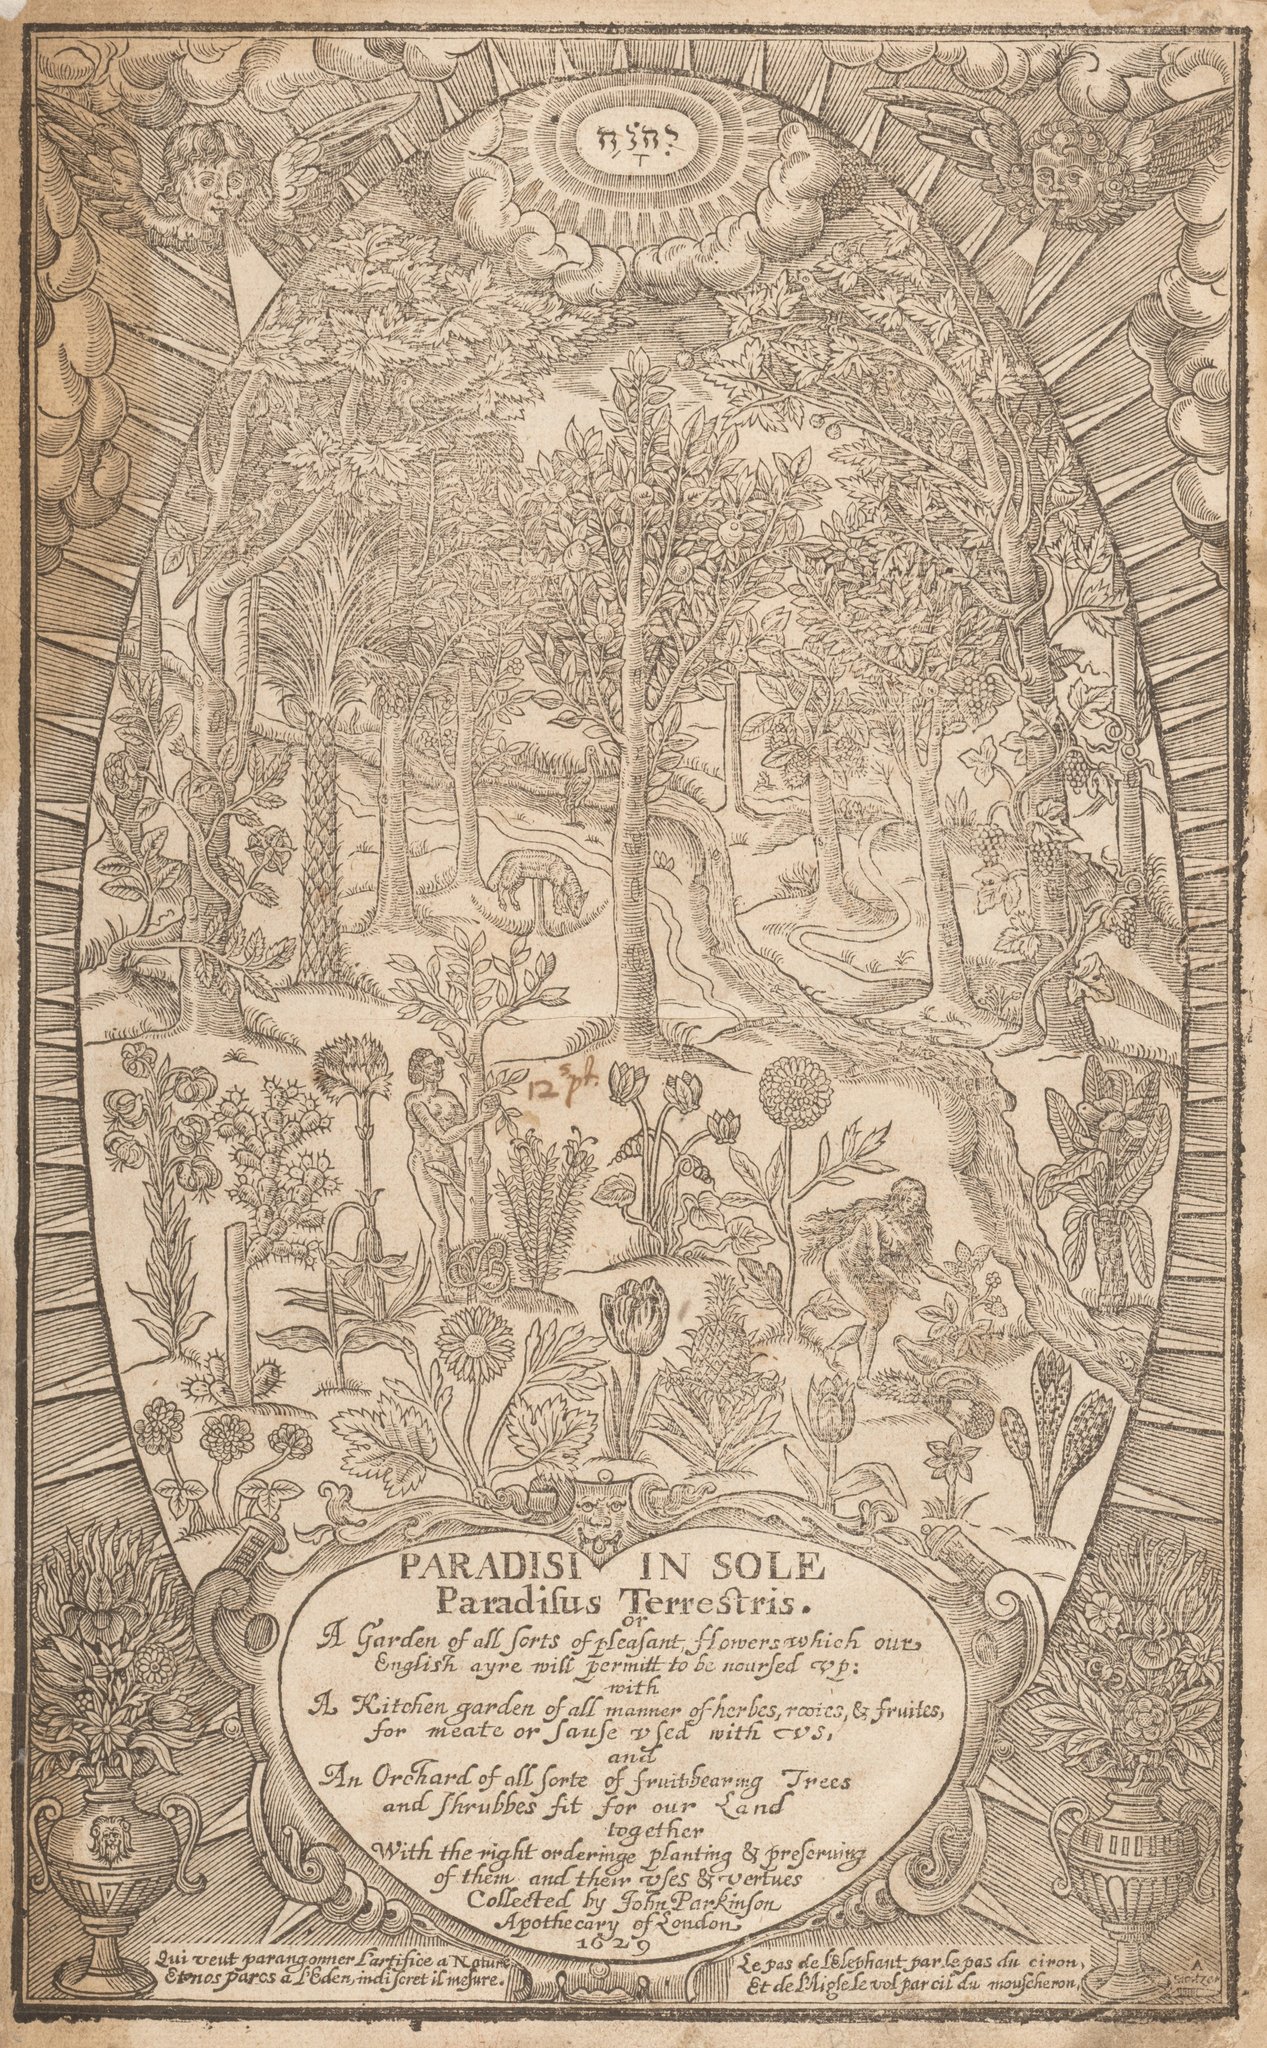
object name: book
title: Paradisi in Sole. Paradisus Terrestris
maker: john parkinson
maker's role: author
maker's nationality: british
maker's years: 1567-1650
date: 1629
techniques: woodcut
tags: male nudes,female nudes,flowers,trees